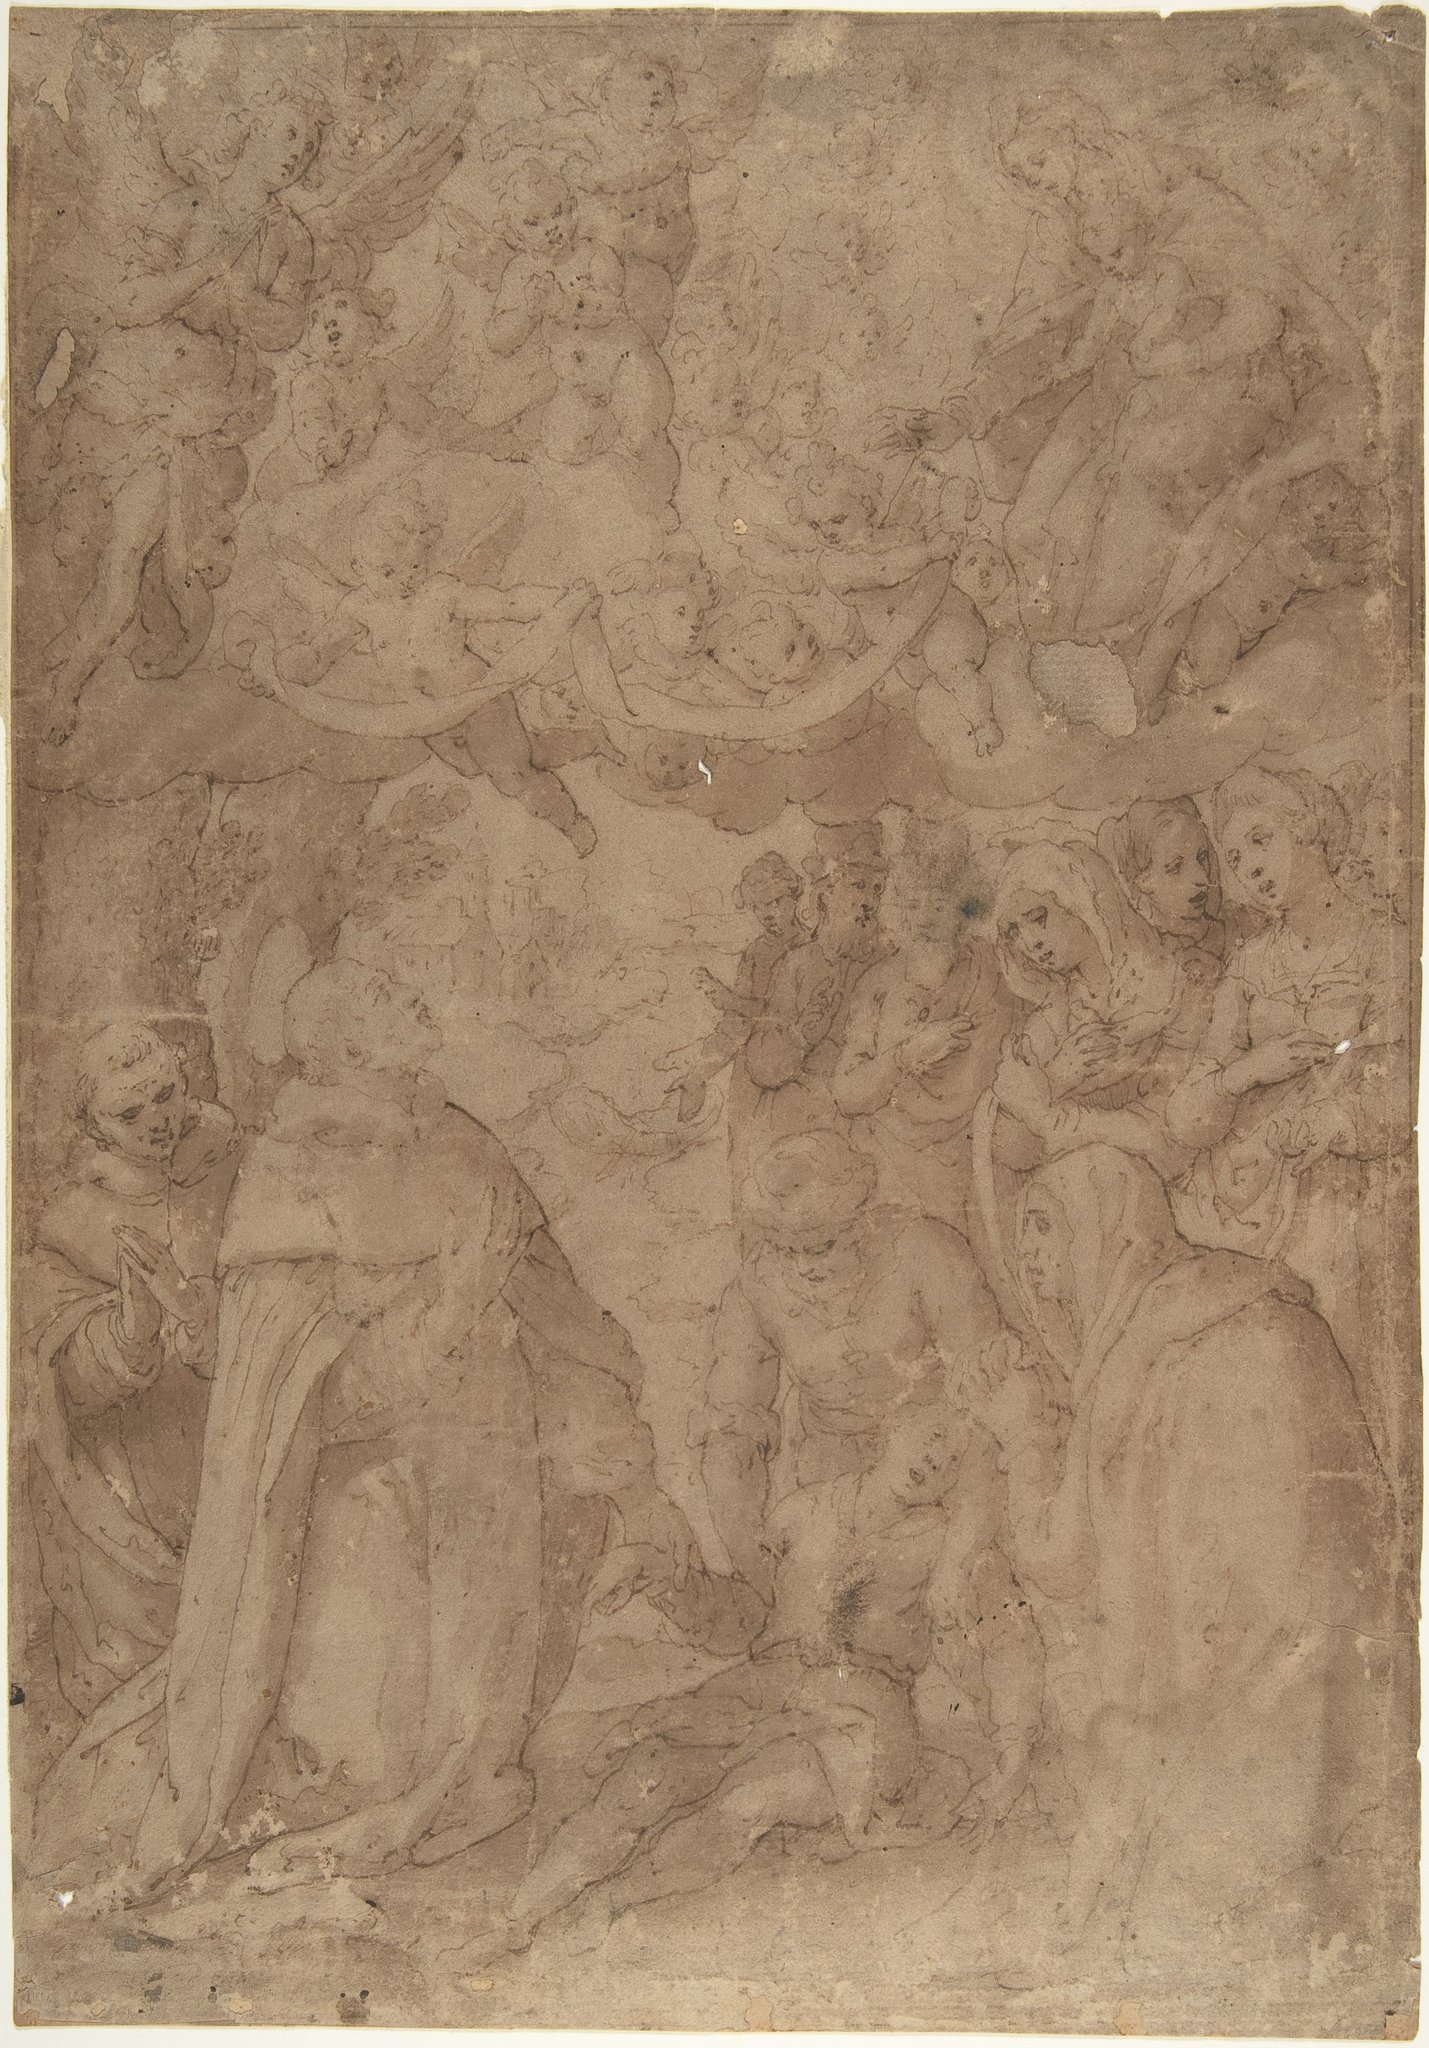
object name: drawing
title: A Saint Healing a Sick Man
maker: anonymous, italian, 16th century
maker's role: artist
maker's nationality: italian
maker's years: 1550-1600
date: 1501-1600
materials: ink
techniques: brush, pen, wash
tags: illness,men,women,putti,saints